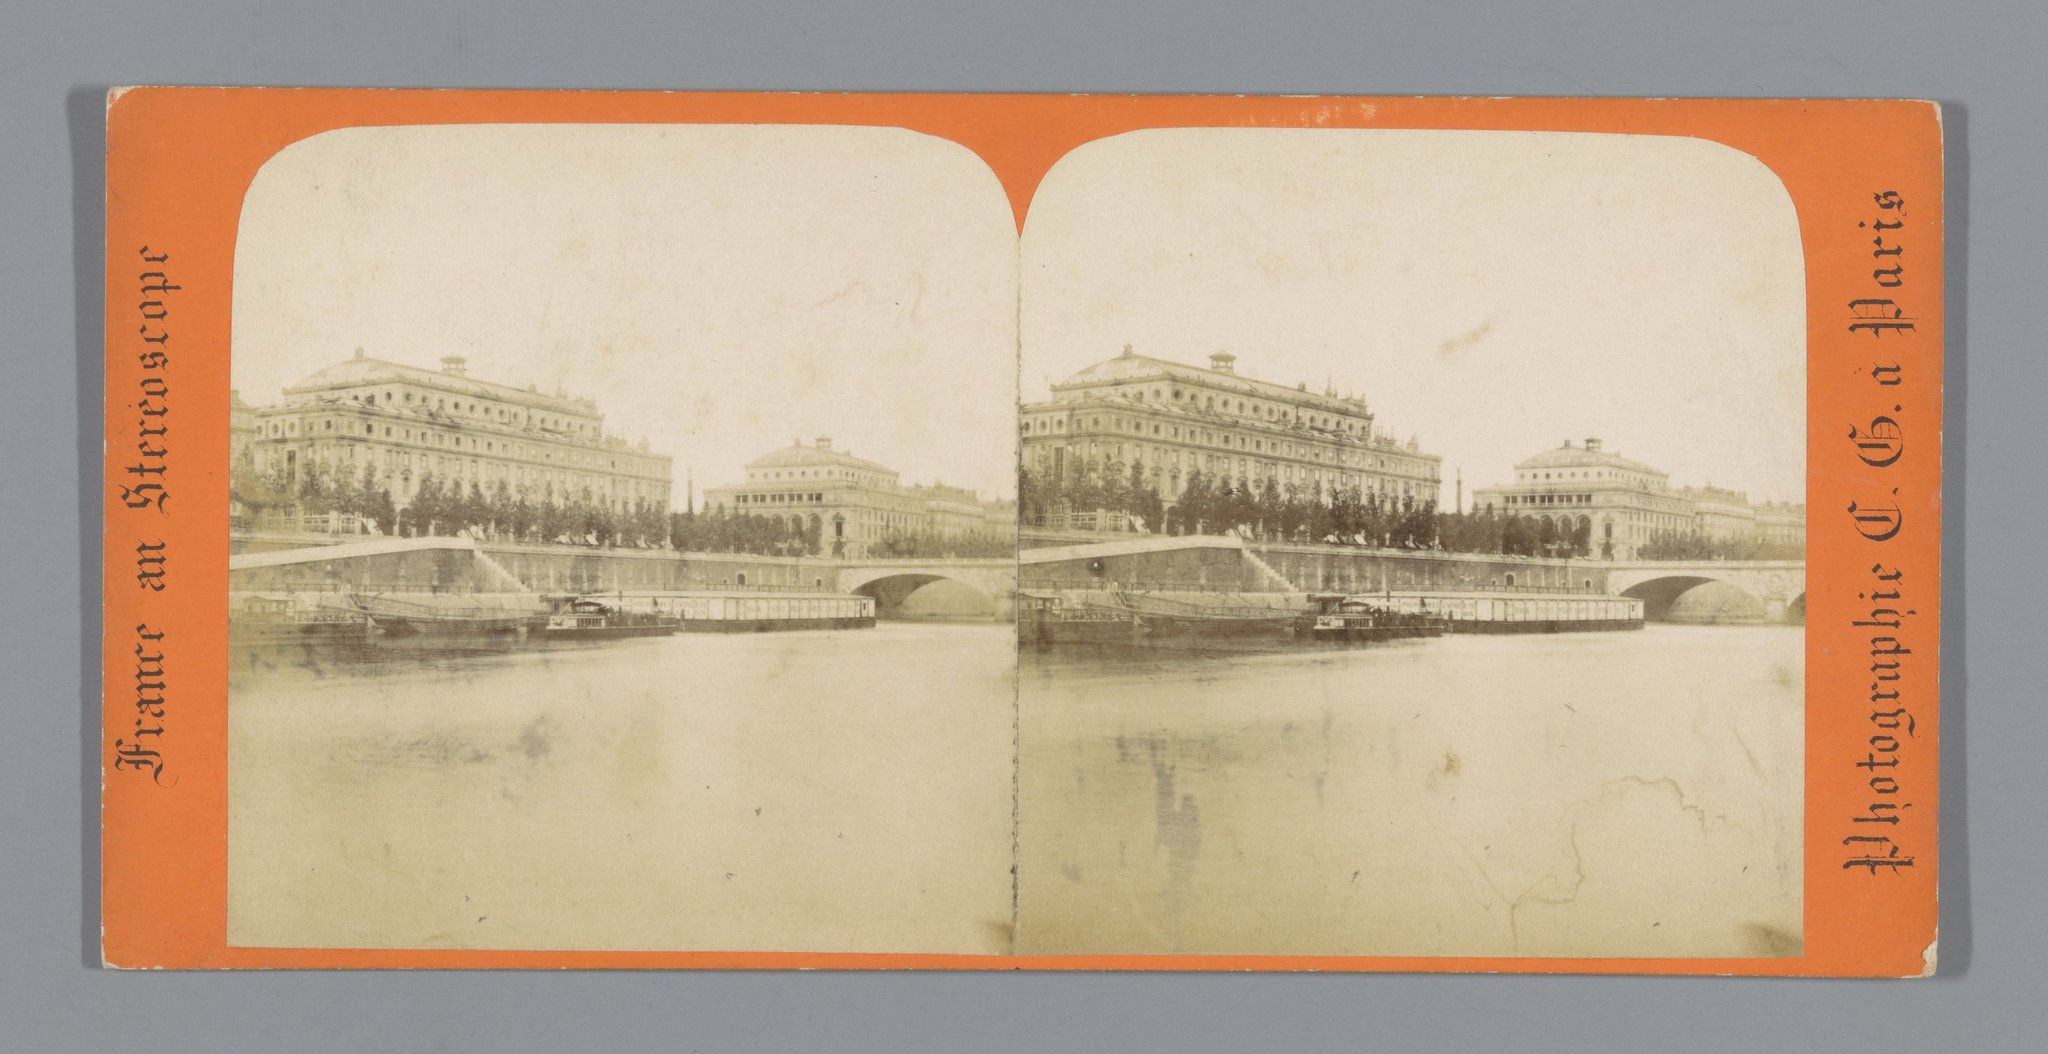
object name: stereograph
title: Gezicht op een kade langs de Seine te Parijs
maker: charles gérard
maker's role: fotograaf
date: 1850-1875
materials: cardboard, photographic support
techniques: albumen print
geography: paris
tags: river, quay, paris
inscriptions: inscription: ‘Une des theatres du Chatelet et du lyrique’